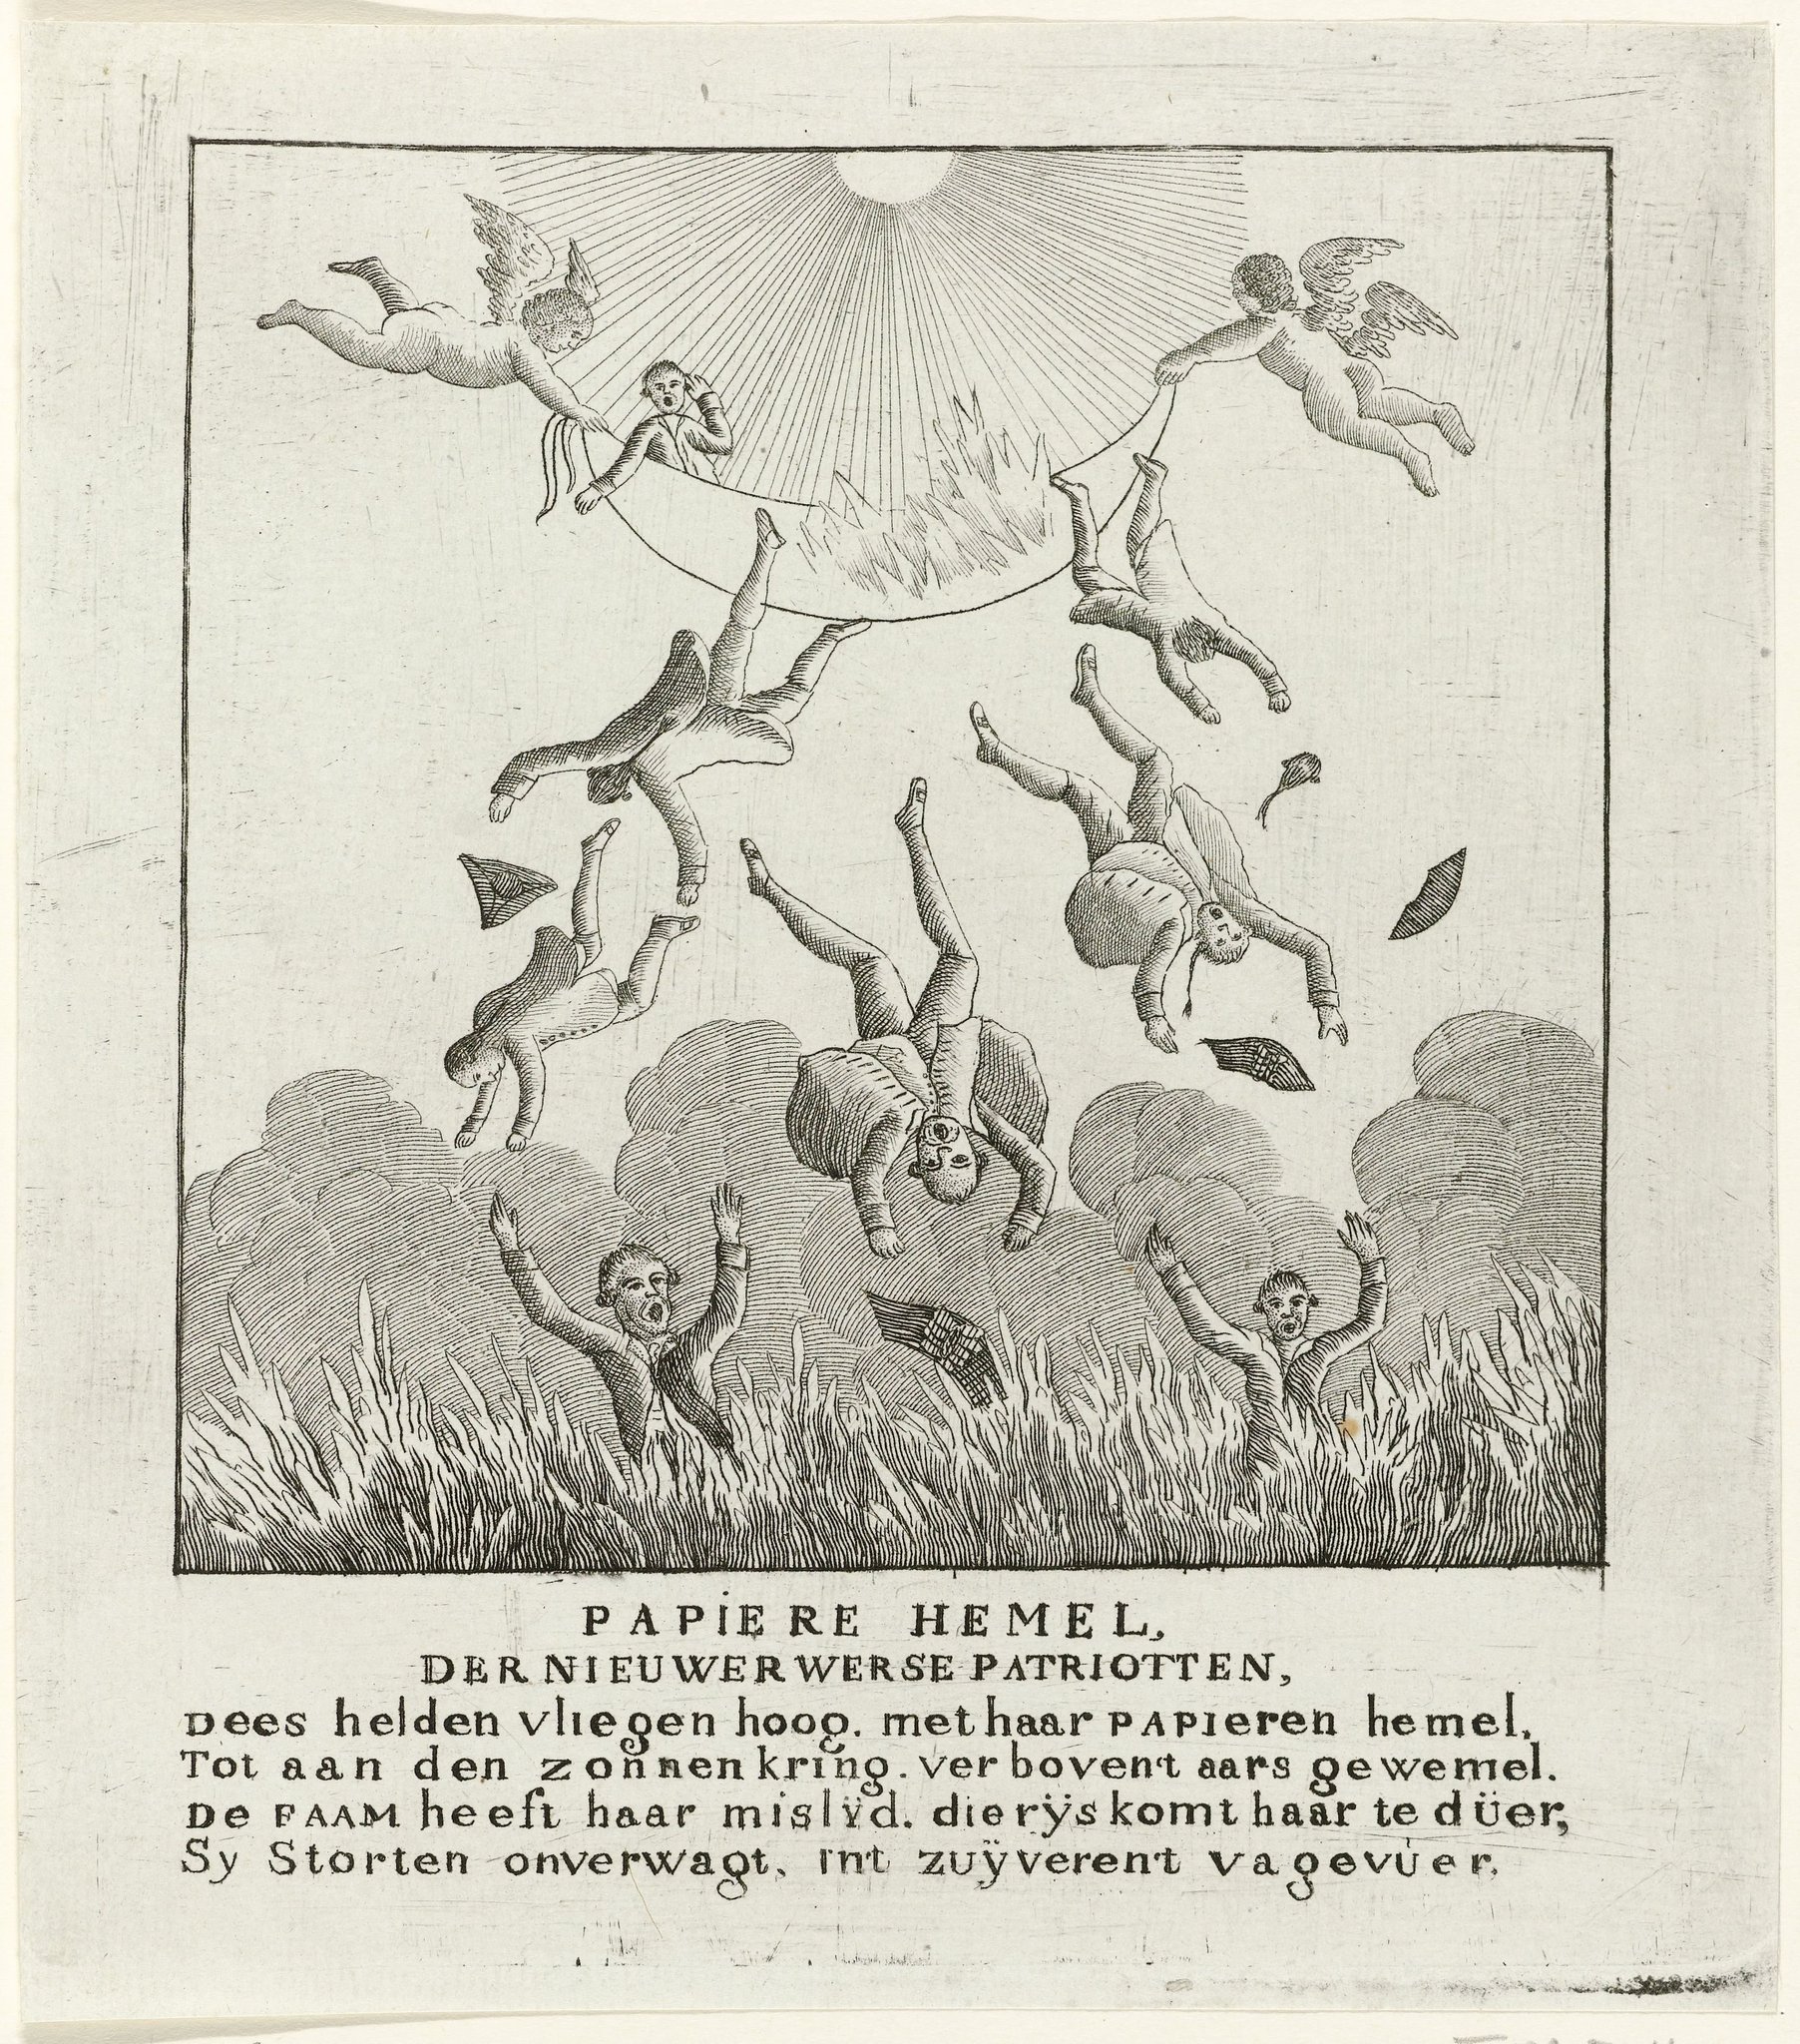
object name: cartoon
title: Papiere Hemel der Nieuwerwerse Patriotten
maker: Anonymous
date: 1787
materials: paper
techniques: engraving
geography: northern netherlands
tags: hell and purgatory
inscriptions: collector's mark: Lugt 2228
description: Spotprent op de patriotten na het herstel van de prins van Oranje in 1787. Het papieren vaartuig waarmee de patriotten naar de hemel vliegen komt te dicht bij de zon en vat vlam en de inzittenden storten omlaag in het hellevuur. Met vierregelig vers.